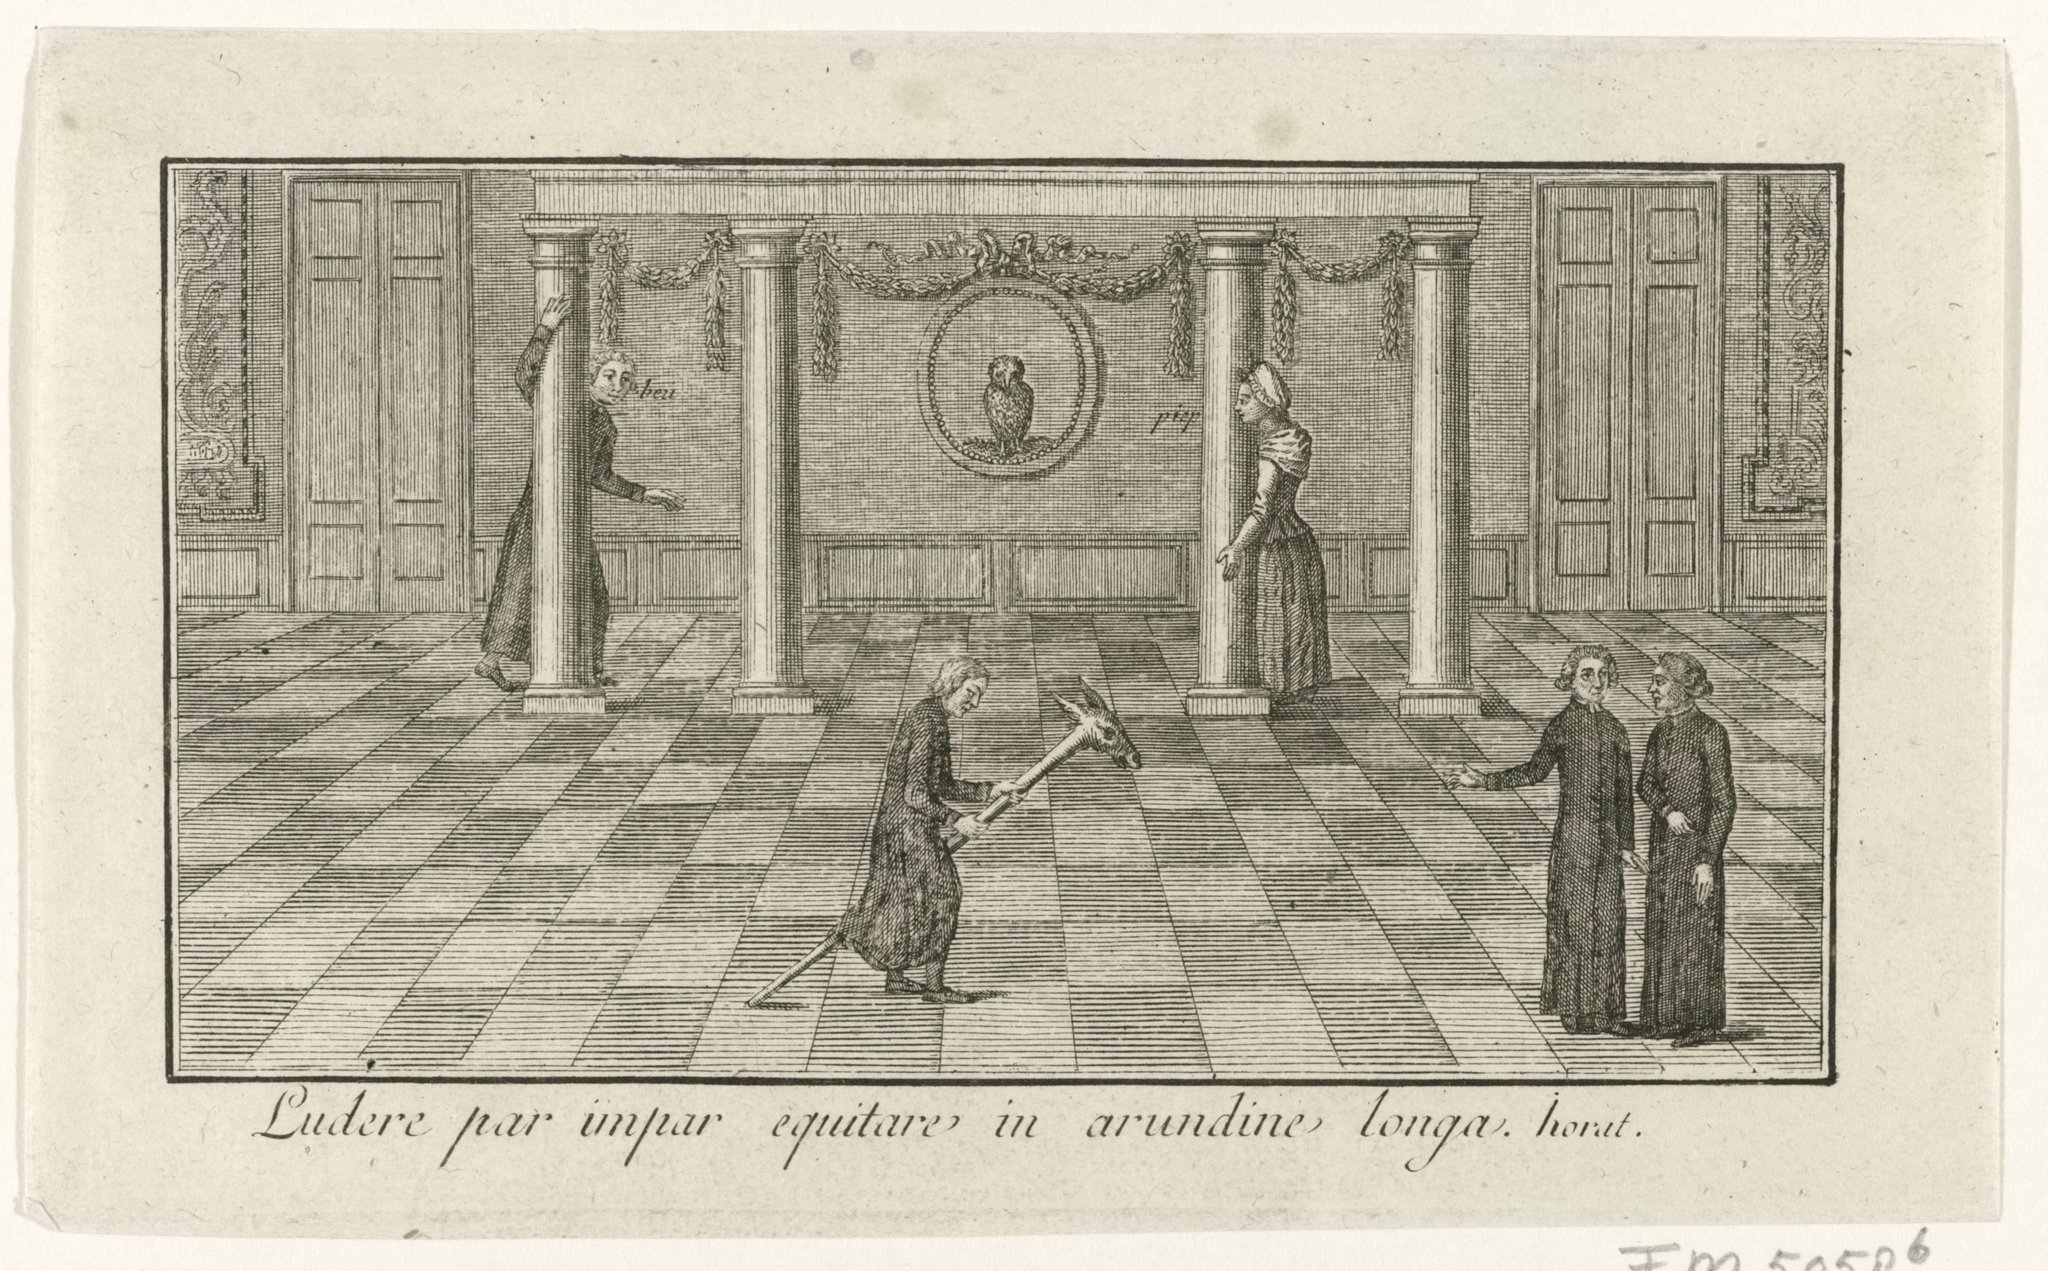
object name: print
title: Brabantse Omwenteling, 1787-1790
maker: Anonymous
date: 1787-1790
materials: paper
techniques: engraving, etching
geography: southern netherlands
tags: hobby-horse, brabant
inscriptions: collector's mark: Lugt 2228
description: Interieur van een zaal waarin een rooms-katholiek op een stokpaardje van een ezel rijdt. Op de achtergrond een man en een vrouw half verstopt achter zuilen, tegen de achterwand een medaillon met een uil. Het Latijnse onderschrift afkomstig uit Horatius. Onderdeel van een grote groep van prenten betrekking hebbend op de gebeurtenissen van de Brabantse Omwenteling en de periode 1787-1790.